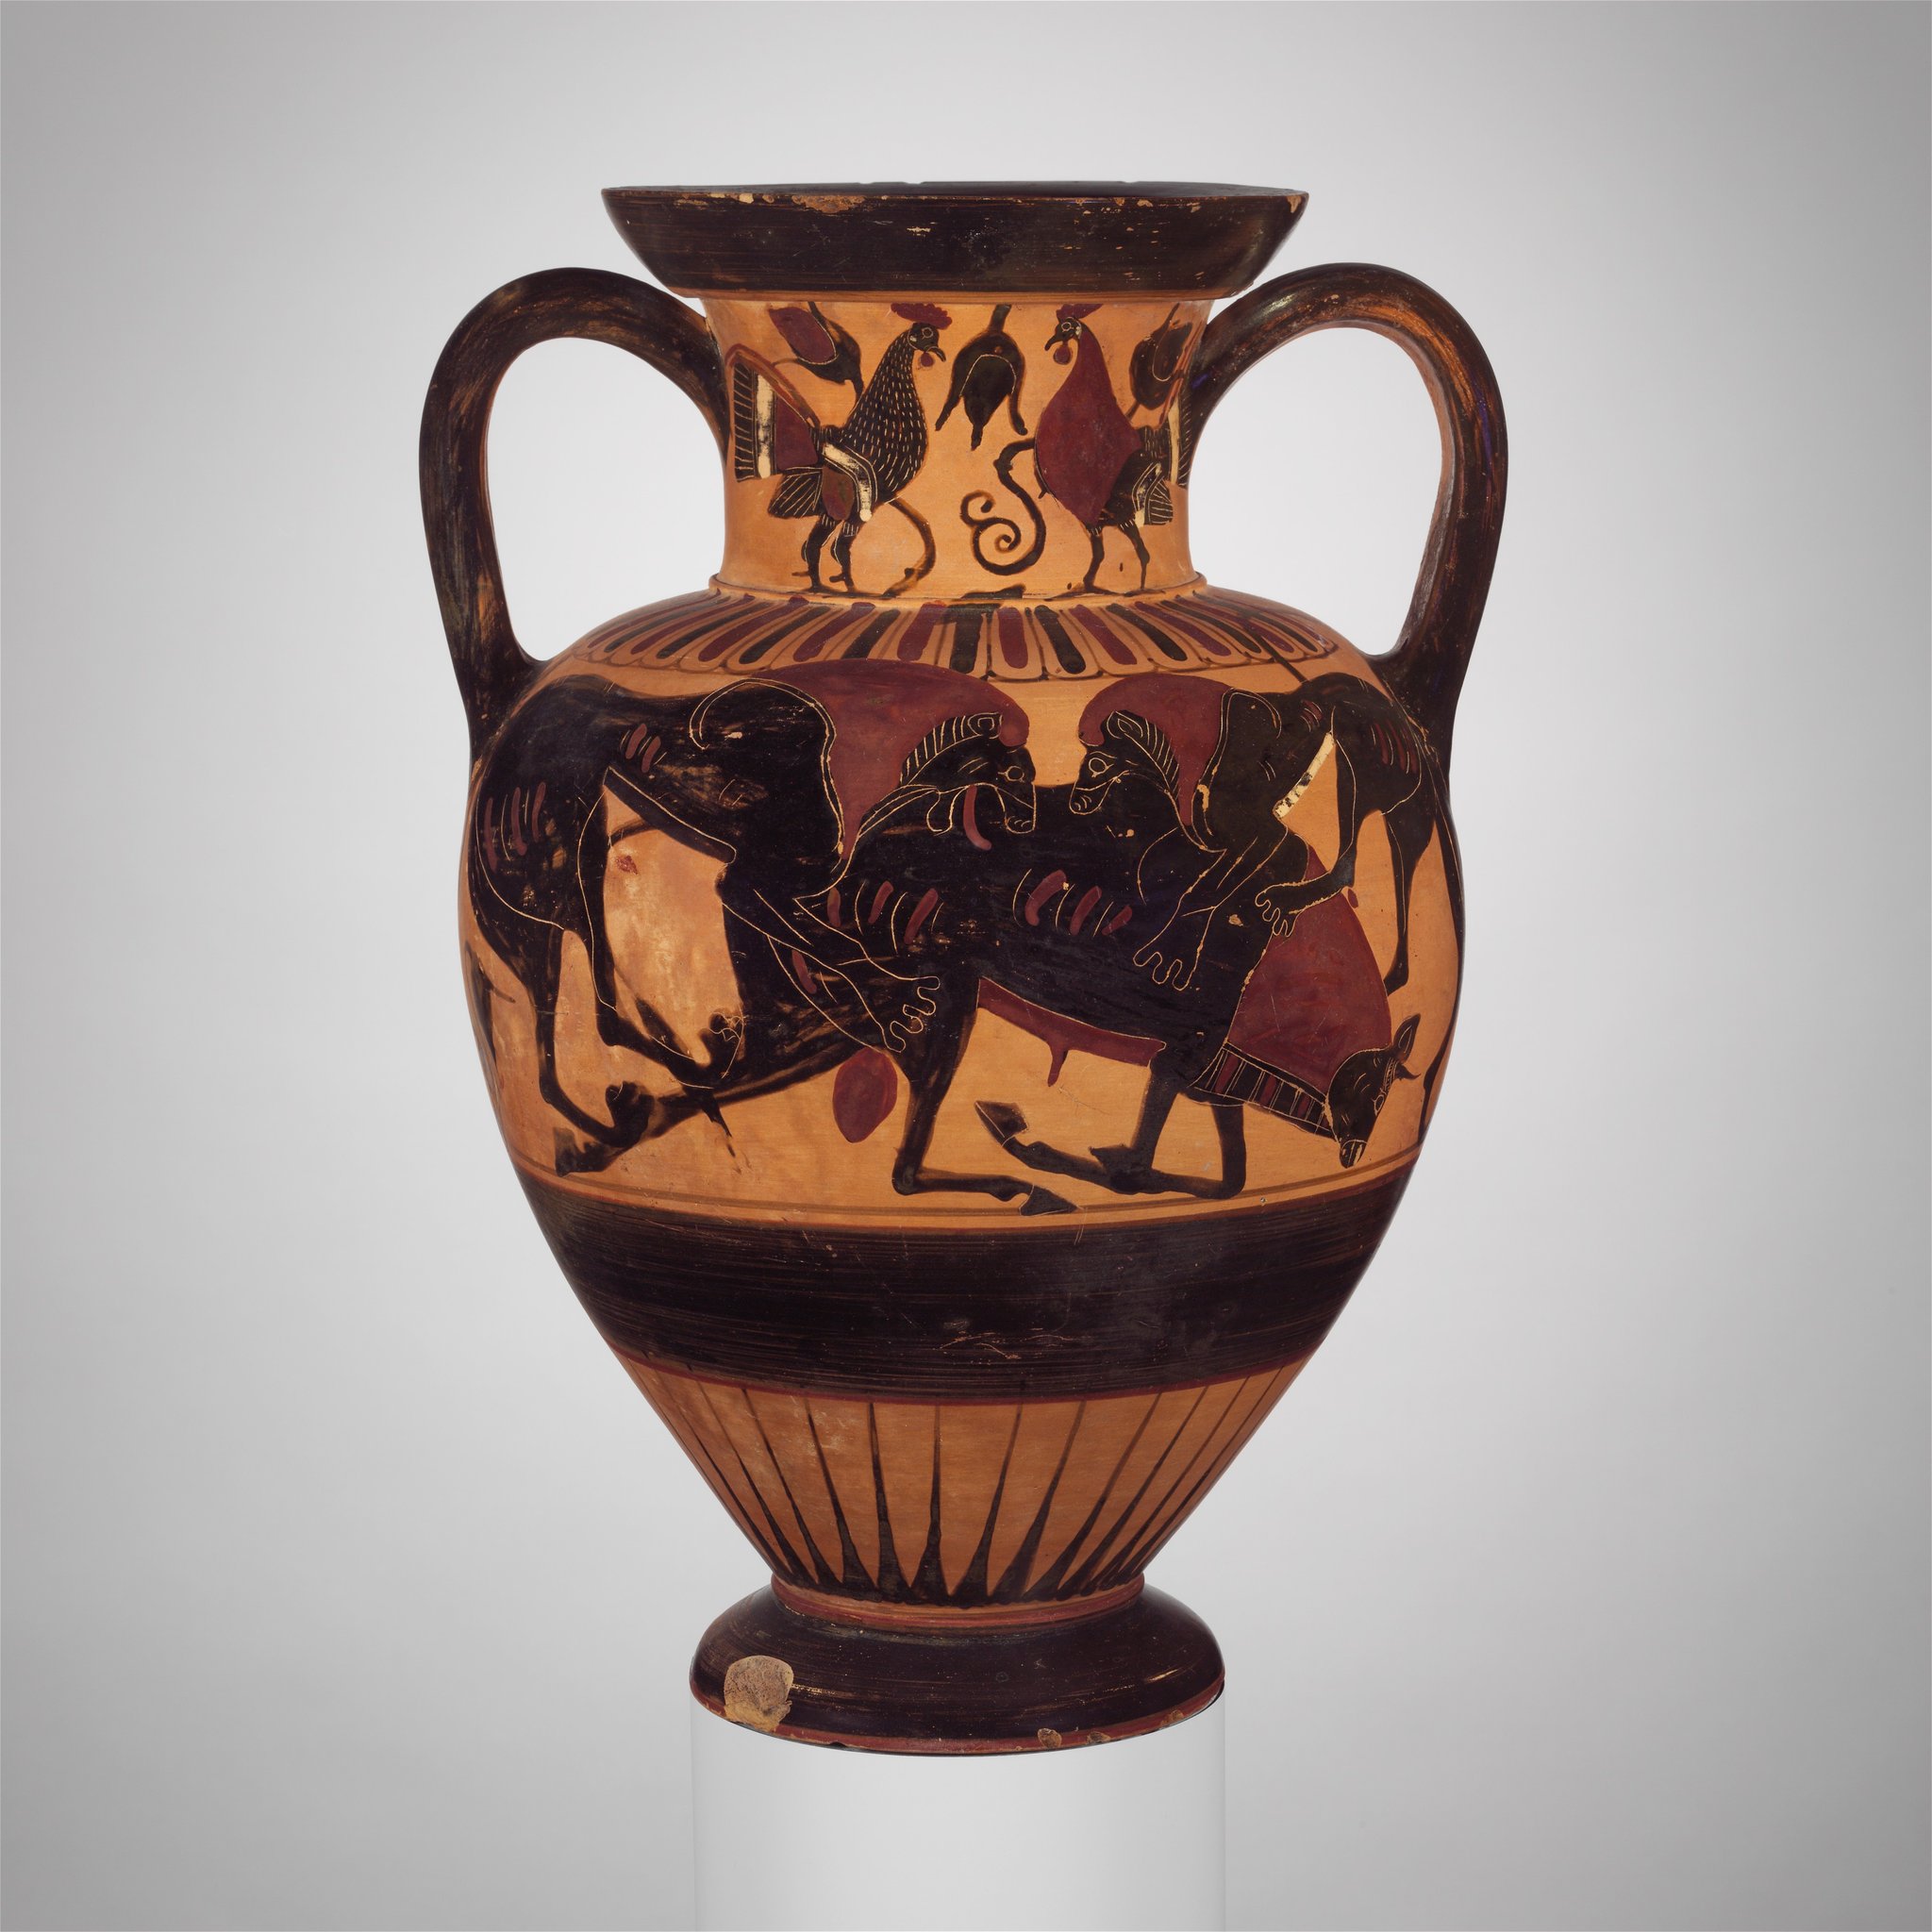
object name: neck amphora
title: Terracotta neck-amphora (jar)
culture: greek, chalcidian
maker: polyphemos group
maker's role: artist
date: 540-530 BCE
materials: terracotta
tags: roosters,bulls,lions